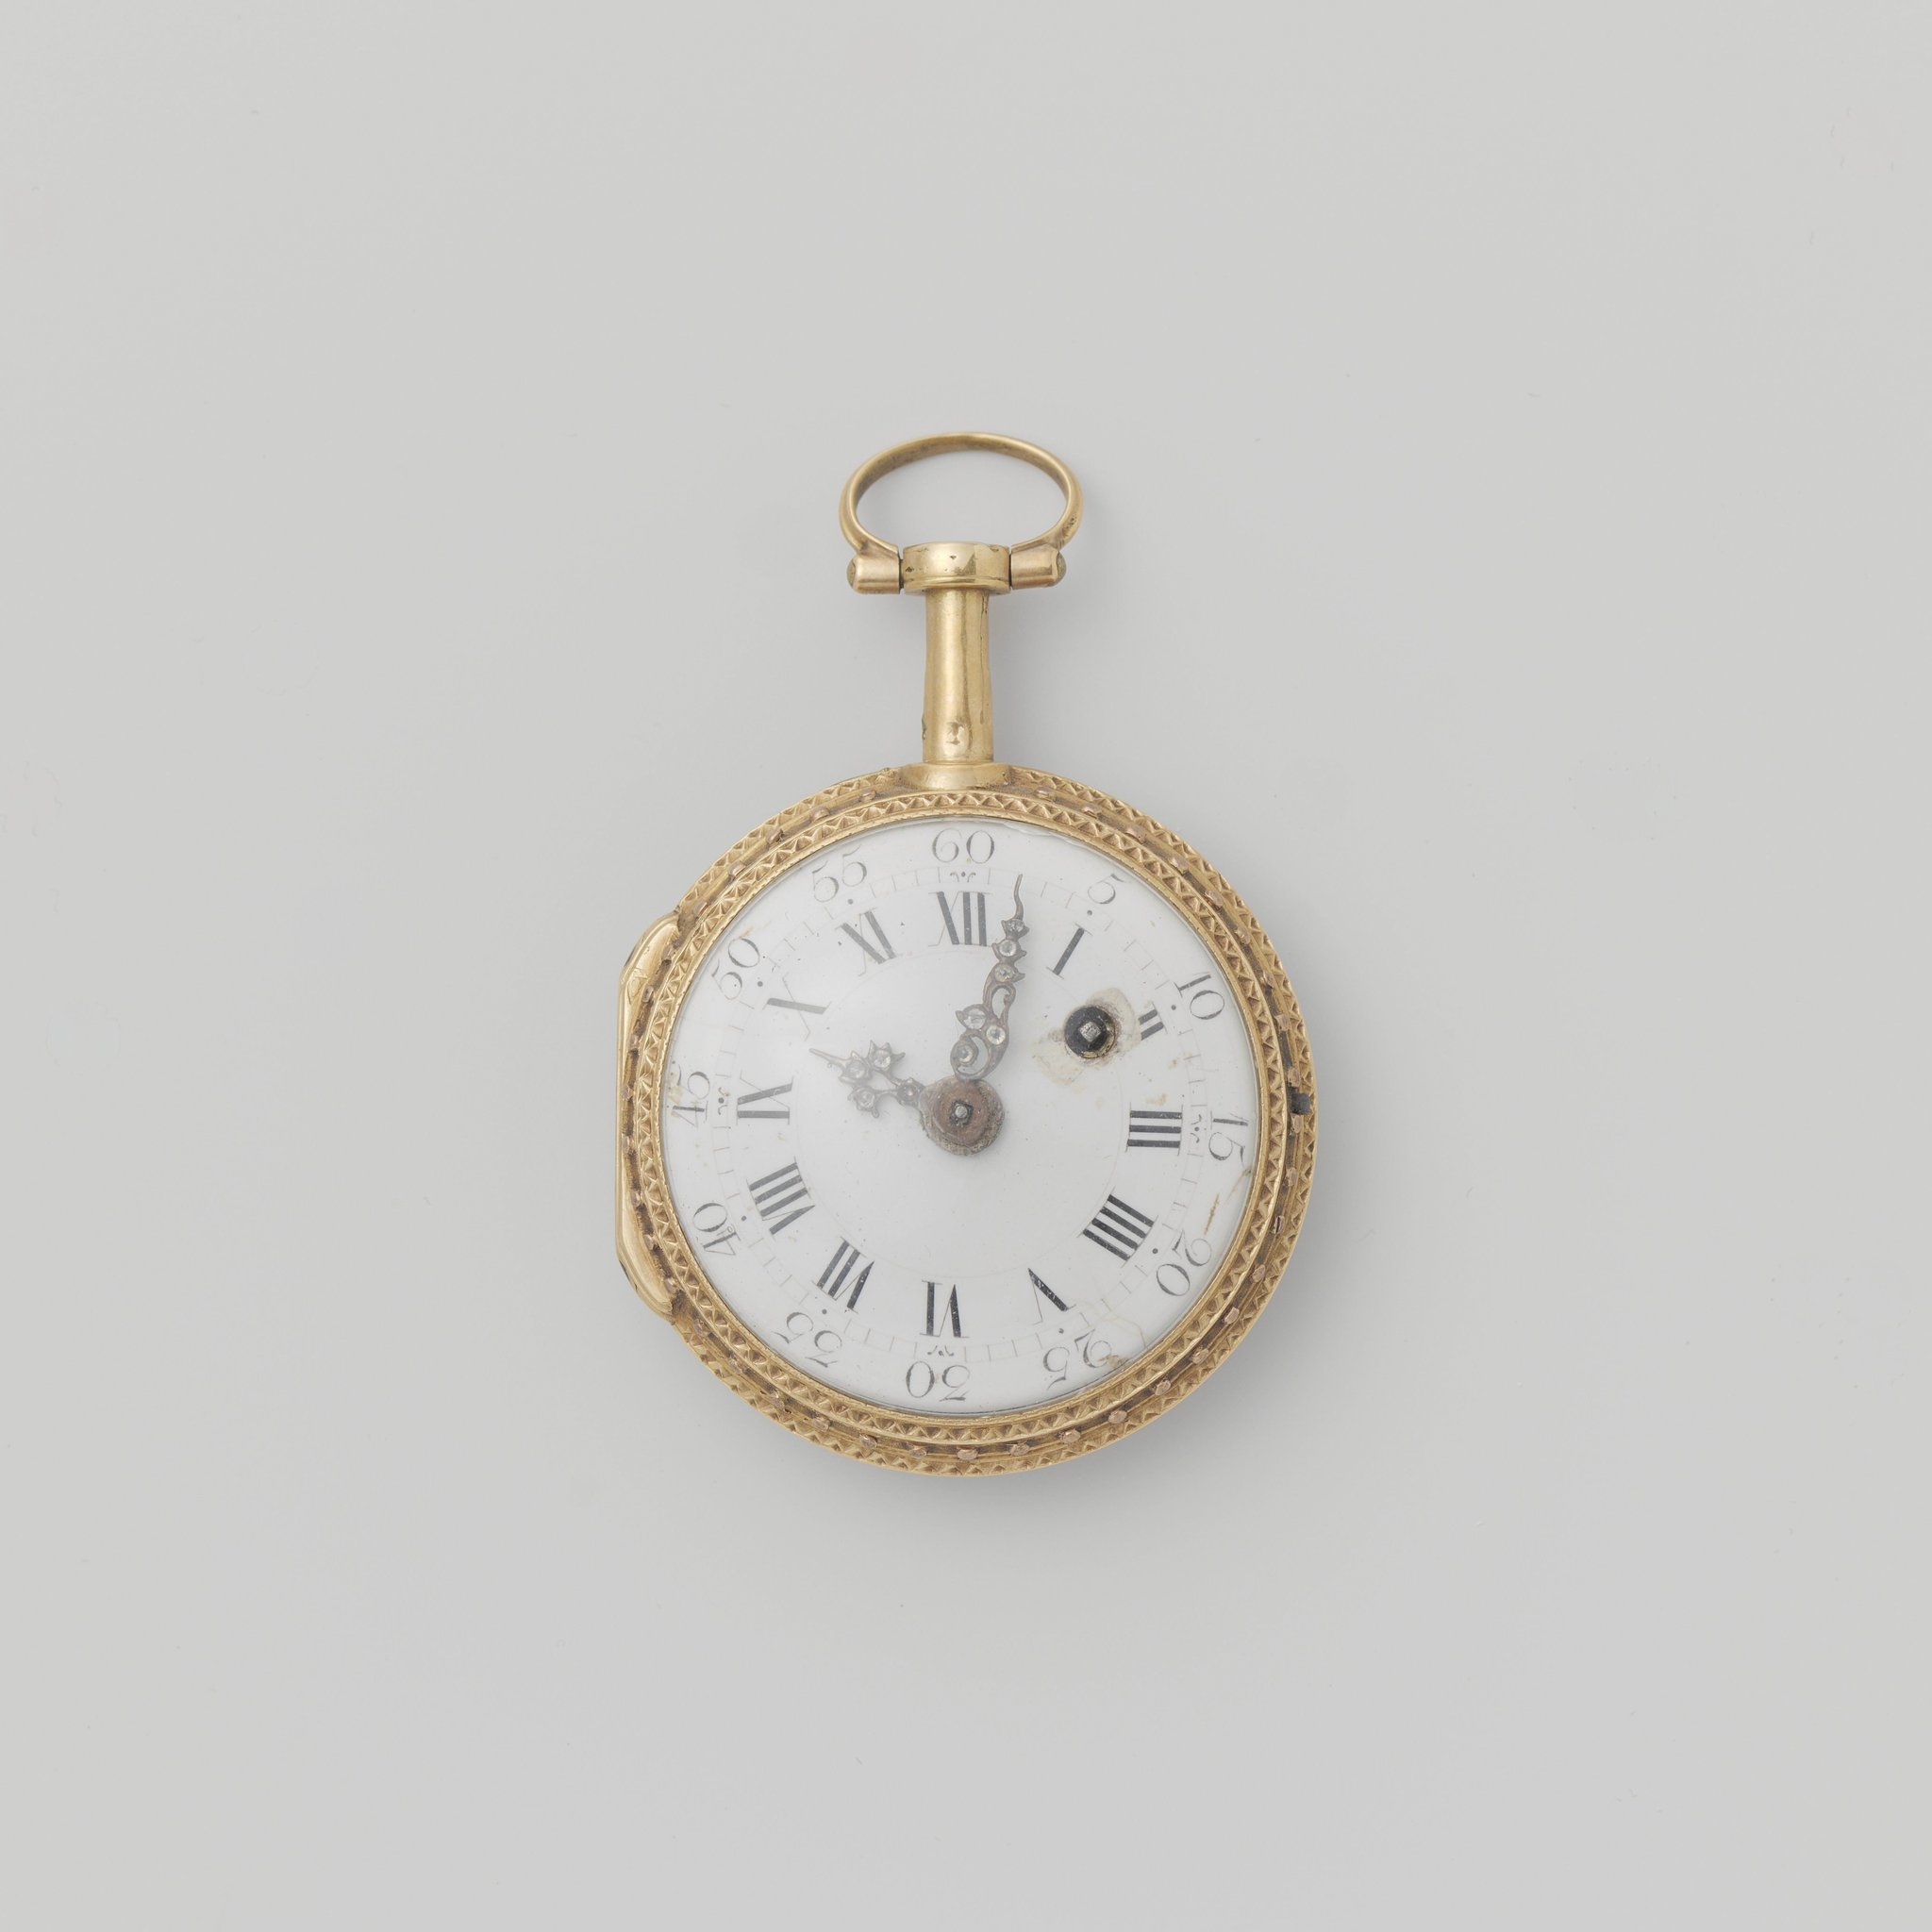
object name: jewellery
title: Watch with Animals at Play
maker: Anonymous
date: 1775-1790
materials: diamond, gold, silver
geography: paris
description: Gouden horloge met een geëmailleerde wijzerplaat, met zilveren wijzers met diamantjes. De achterbodem is versierd met een à quatre couleur geciseleerde voorstelling van een hond opspringend tegen een altaar met twee duiven.